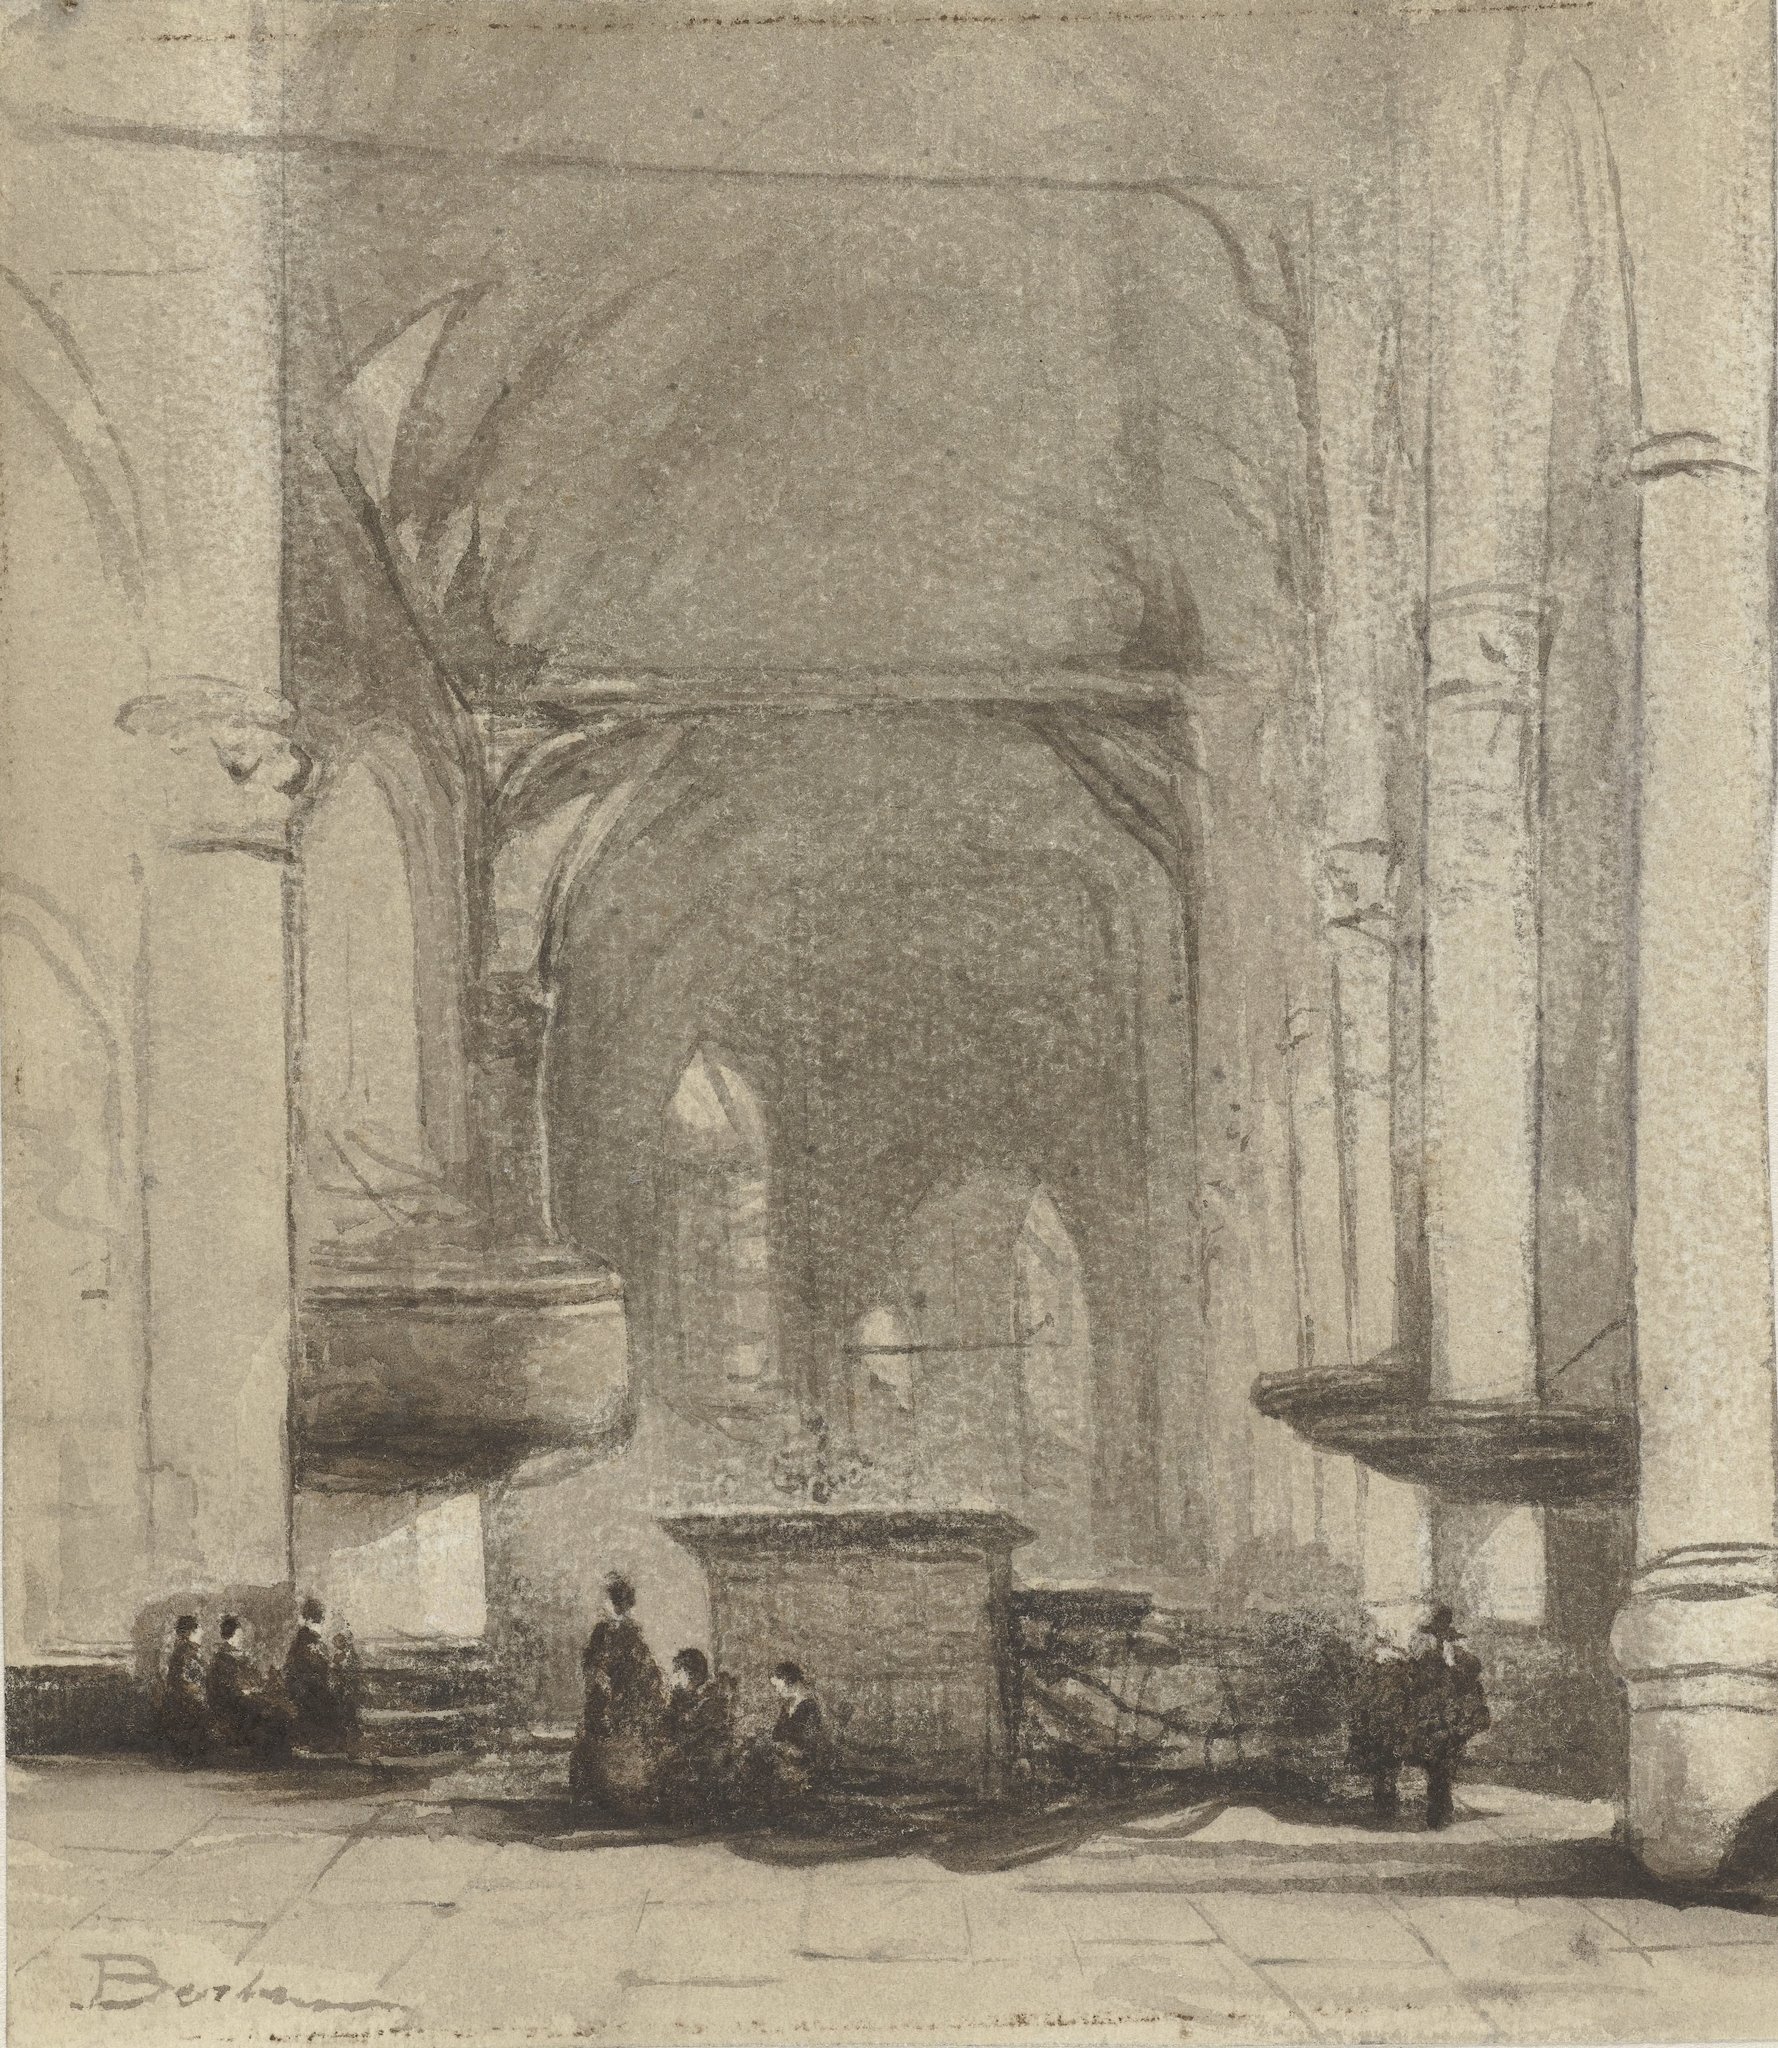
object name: drawing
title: Interieur van de Oude Kerk in Amsterdam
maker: johannes bosboom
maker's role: draughtsman, painter, print maker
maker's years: 1817-1891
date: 1827-1891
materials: chalk, paper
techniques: brush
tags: interior of church